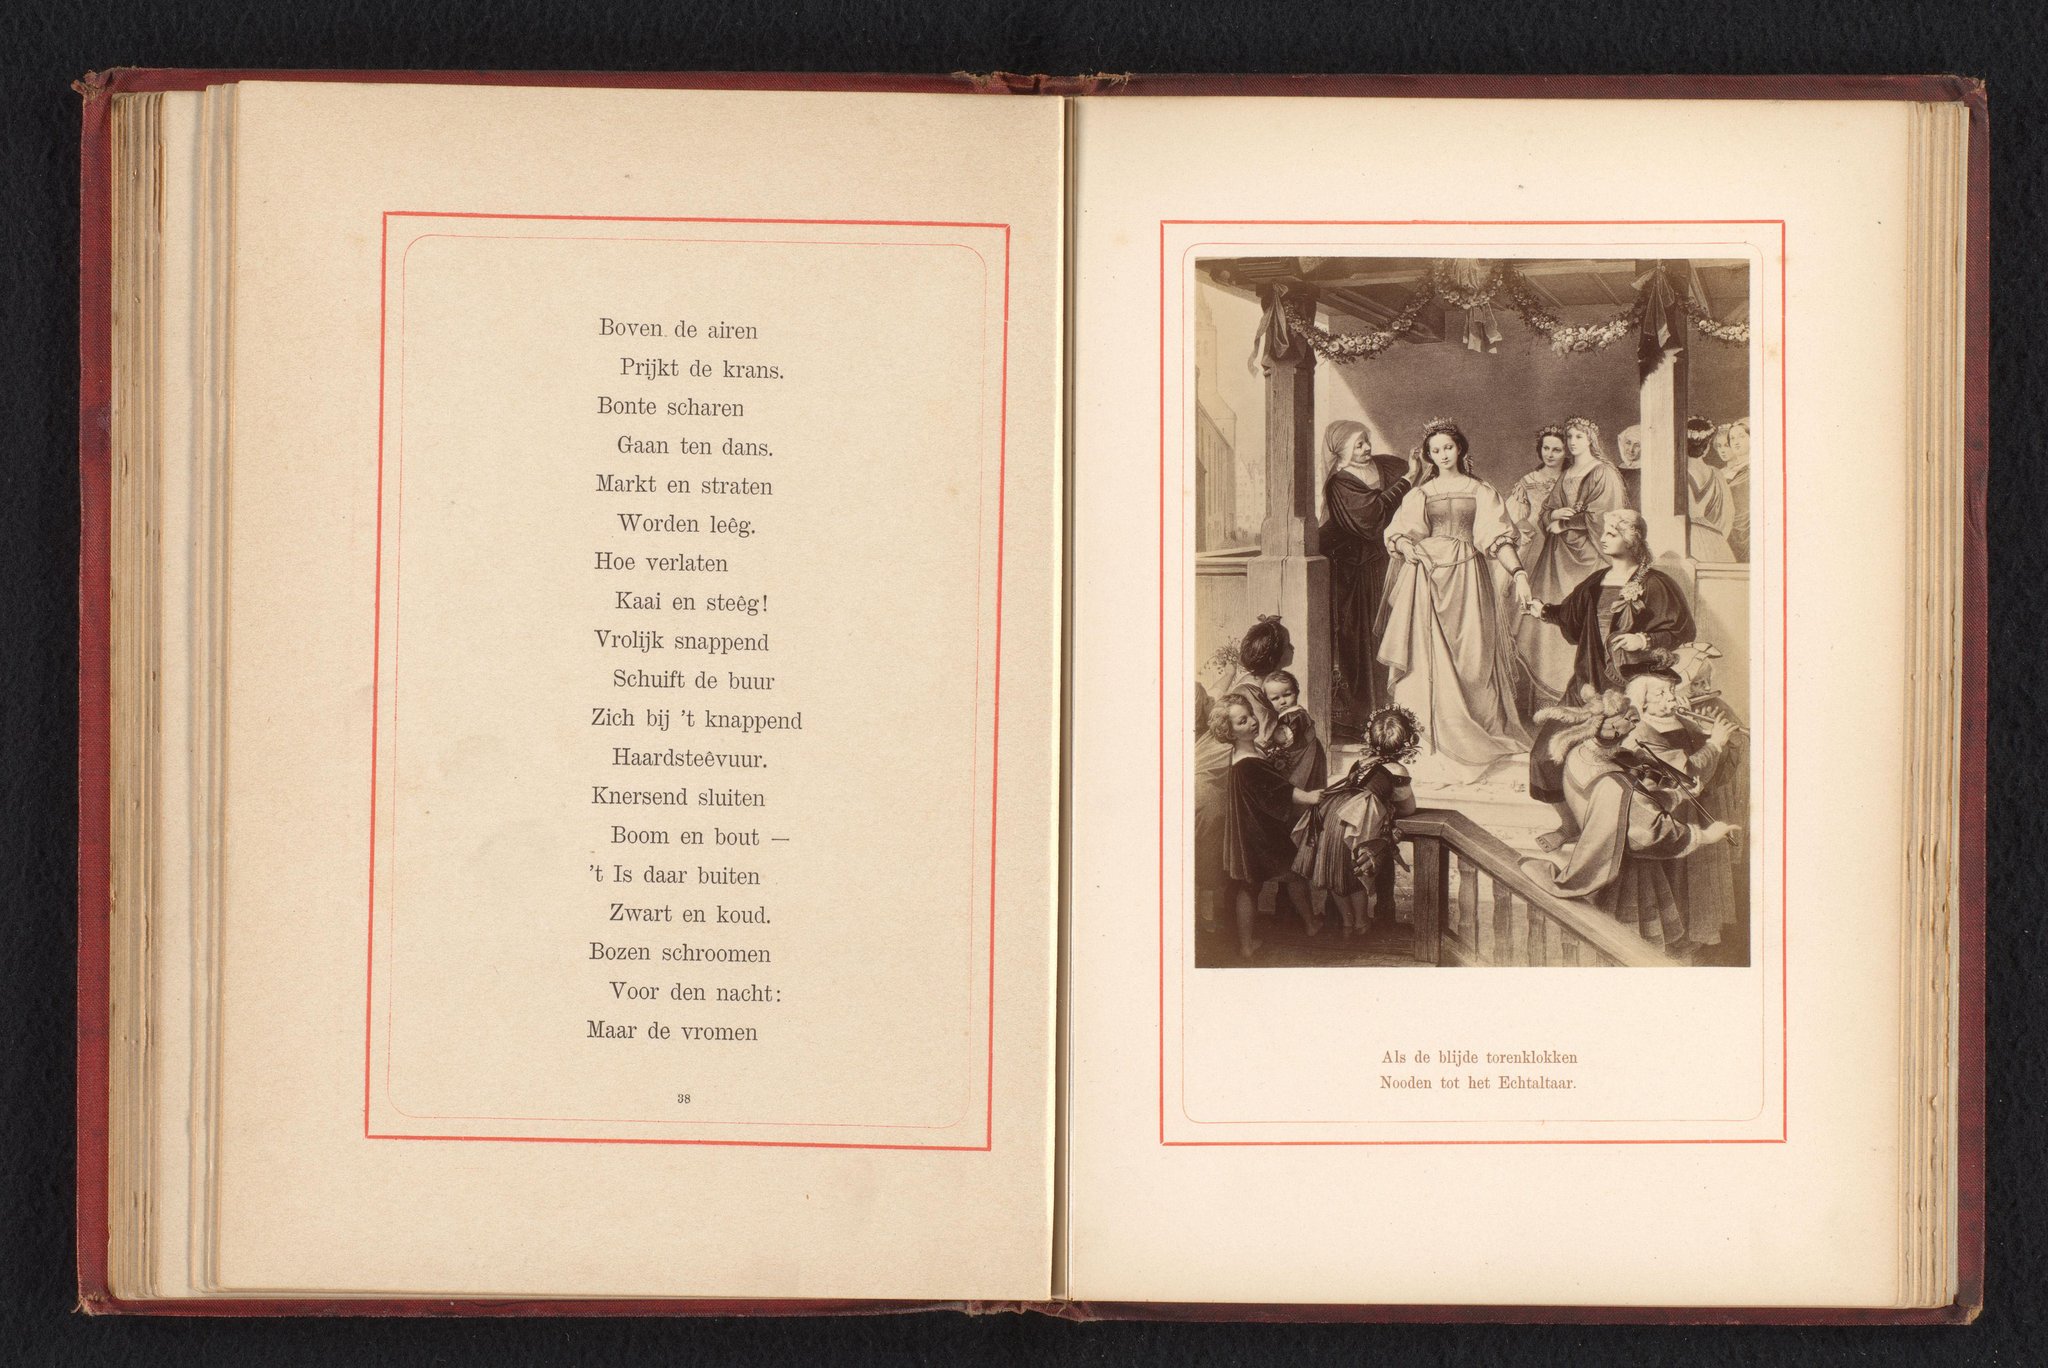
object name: reproduction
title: Fotoreproductie van schilderij van een bruid op weg naar het altaar door Andreas Müller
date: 1874-1879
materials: paper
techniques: albumen print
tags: (civil) marriage ceremonies, picture, painting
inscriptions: inscription: ‘Als de blijde torenklokken/ Nooden tot het Echtaltaar.’